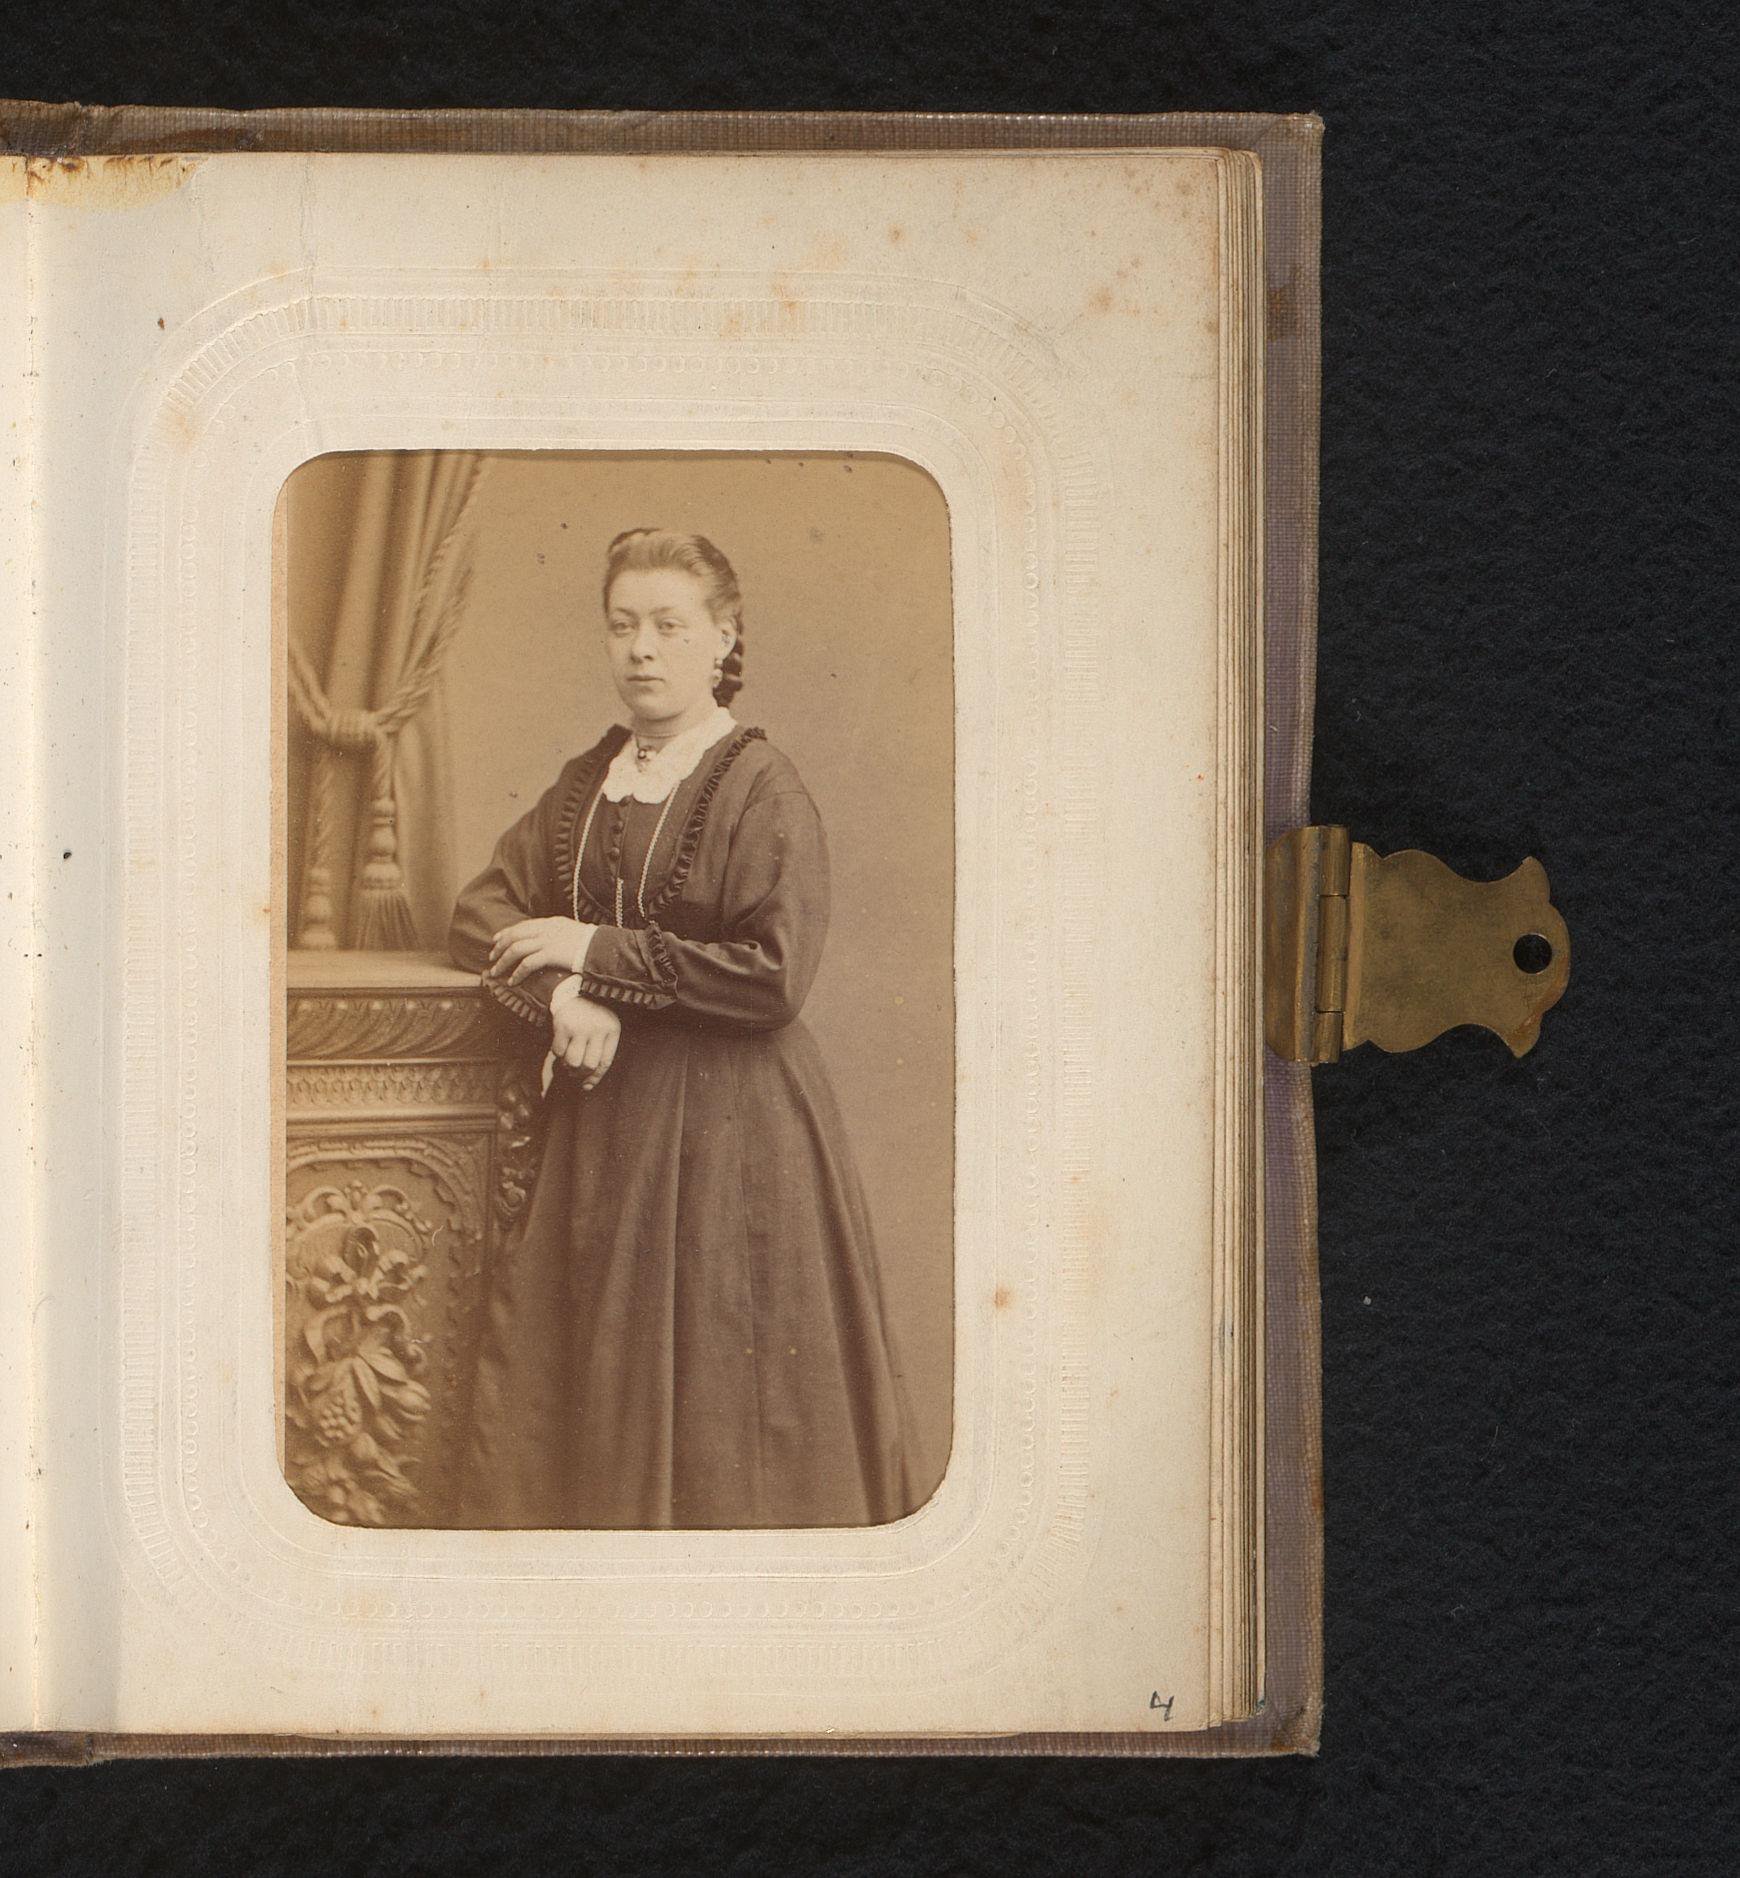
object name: carte de visite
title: Portret van een jonge vrouw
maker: albert greiner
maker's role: fotograaf, fotostudio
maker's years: 1833-1890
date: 1861-1874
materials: cardboard, photographic support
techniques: albumen print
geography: amsterdam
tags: adolescent, young woman, maiden, historical persons - bb - woman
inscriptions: inscription: ‘A. Greiner/ Photograf/ NIEUWENDIJK L. 87/ AMSTERDAM’